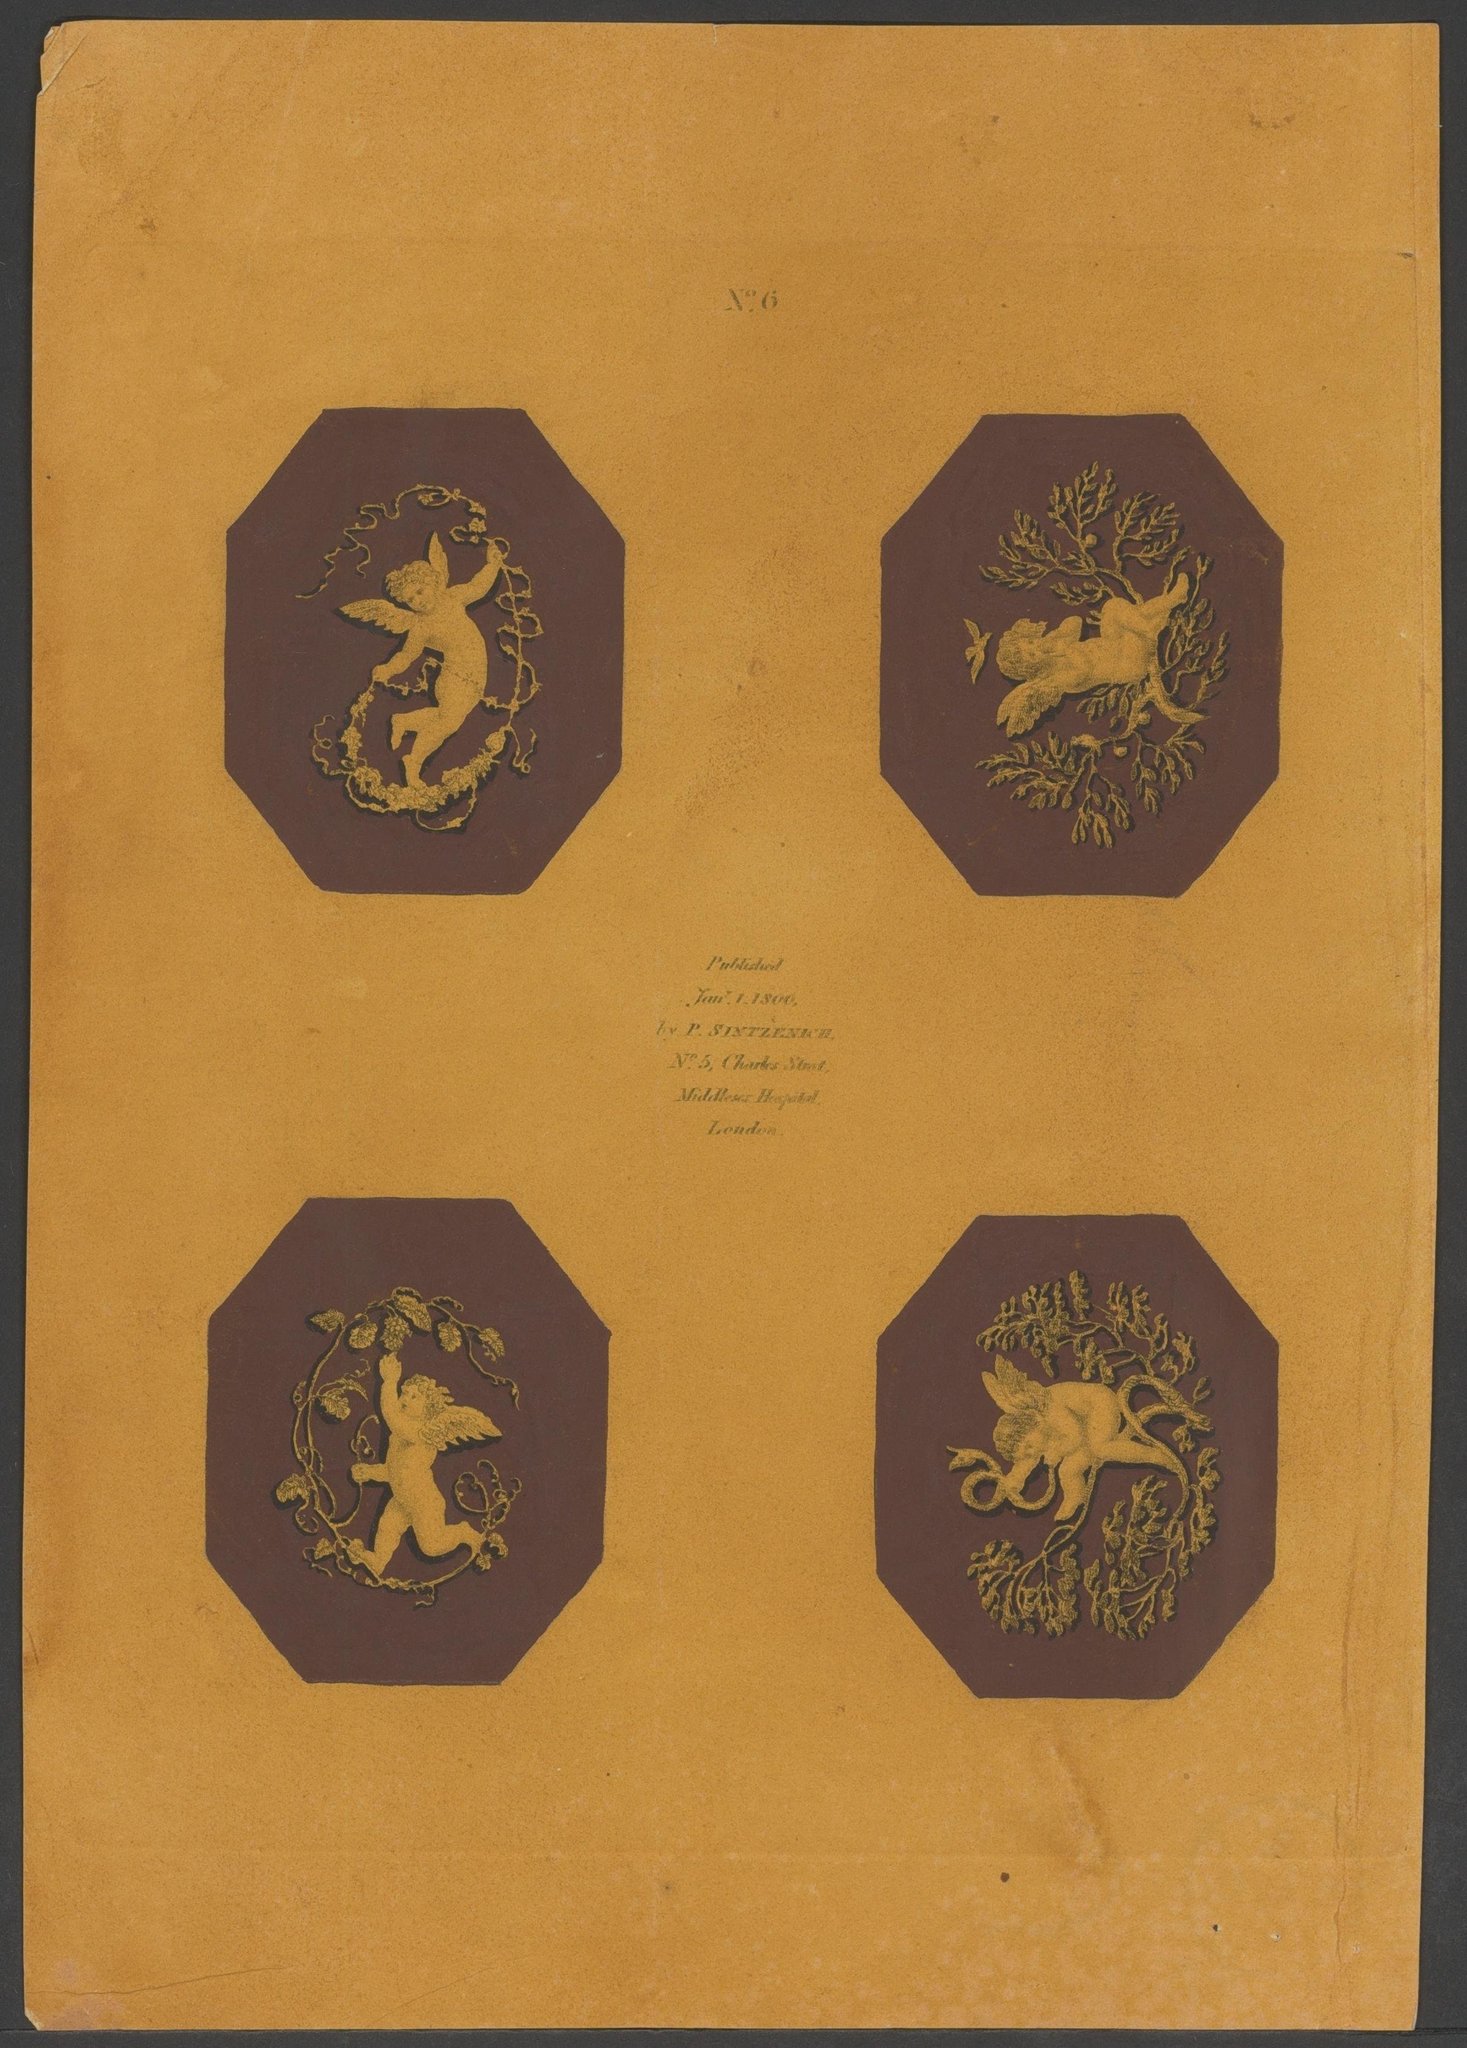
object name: print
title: Vier putti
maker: peter sintzenich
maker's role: print maker, publisher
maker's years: 1779-1808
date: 1775-1825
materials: paper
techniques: etching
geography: london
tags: vine, foliage ~ ornament, cupids: 'amores', 'amoretti', 'putti'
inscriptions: stamp, collector's mark: Lugt 1641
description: Vier achthoeken met in elk een putto omringd door wijnranken of boomtakken. Bovenaan genummerd: No. 6. Onderwerpsrubrieken binnen de Atlas Zeden en Gewoonten: Schoone kunsten, Varia.